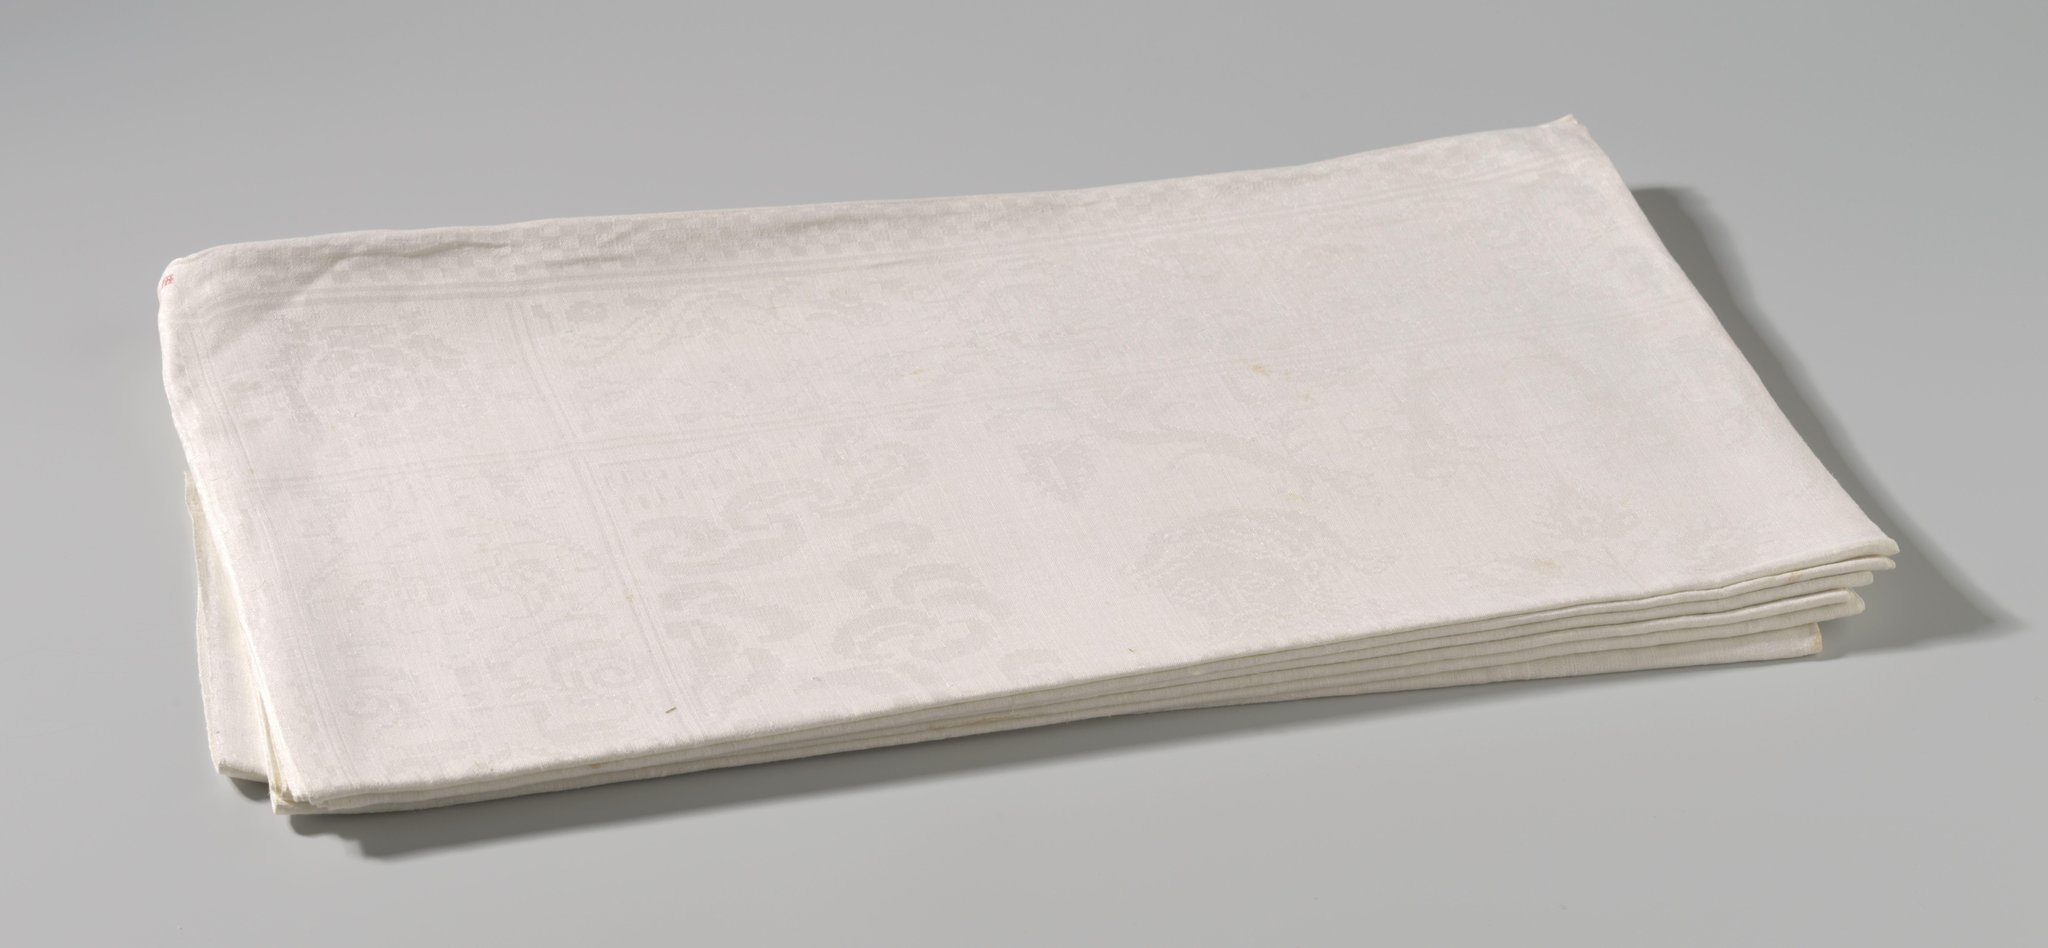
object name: tablecloth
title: Tafellaken met het Offer van Abraham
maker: quirijn jansz. damast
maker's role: mayor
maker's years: 1580-1638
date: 1600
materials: linen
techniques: damask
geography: haarlem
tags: the sacrifice of isaac (genesis 22)